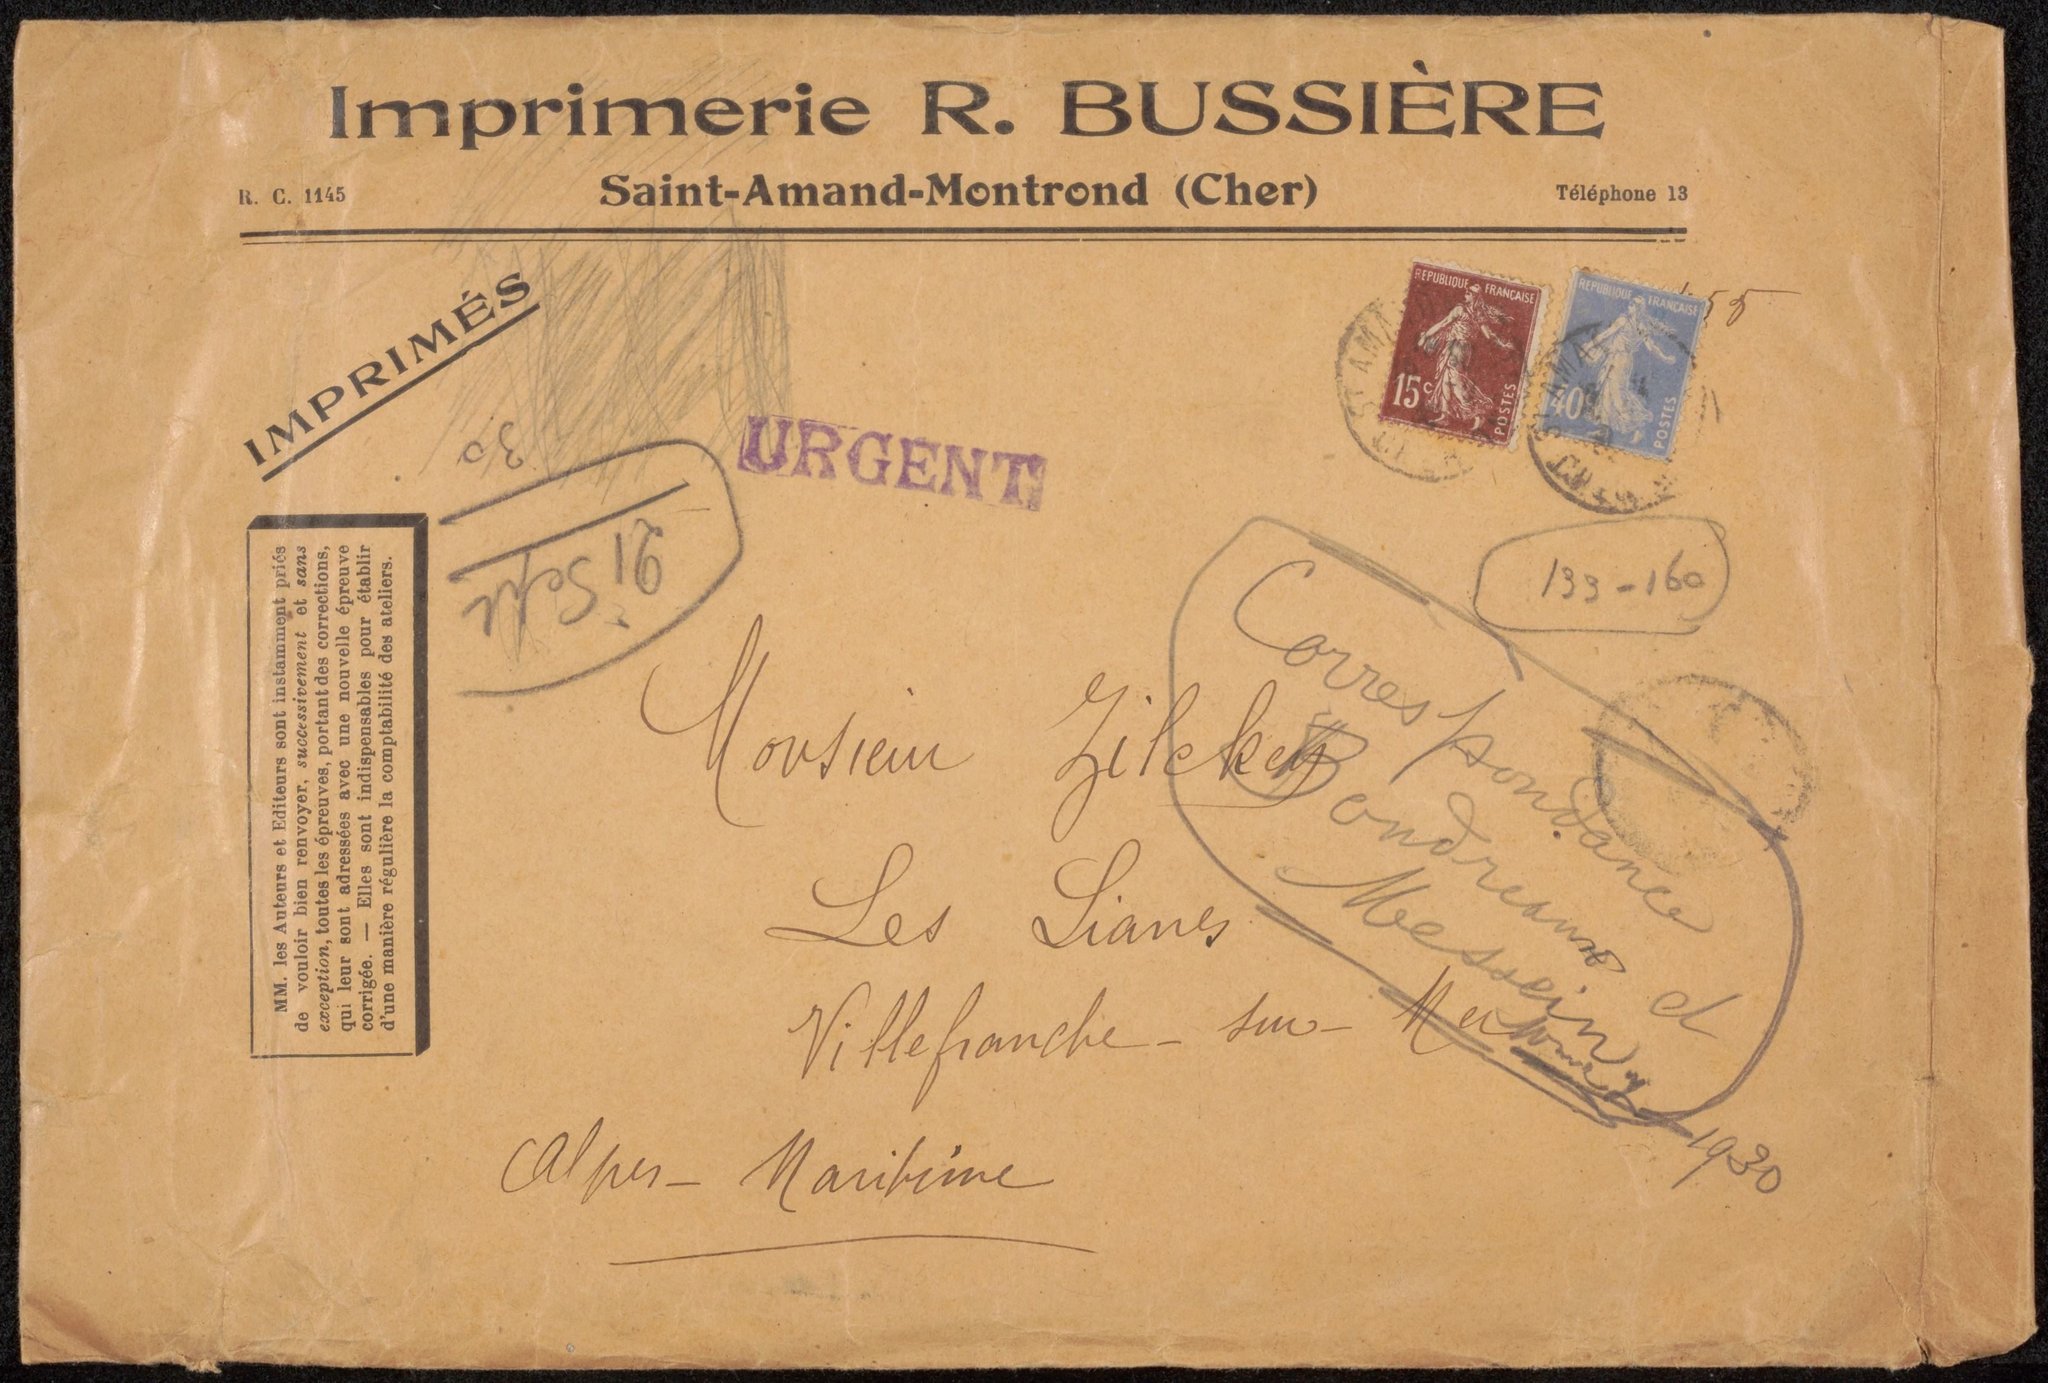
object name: letter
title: Brief aan Philip Zilcken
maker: Anonymous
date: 1930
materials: ink, paper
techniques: pen, printing, typewriting, writing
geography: saint-amand-montrond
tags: paris, publisher, albert messein, the hague, painter, draughtsman, philip zilcken, printed matter